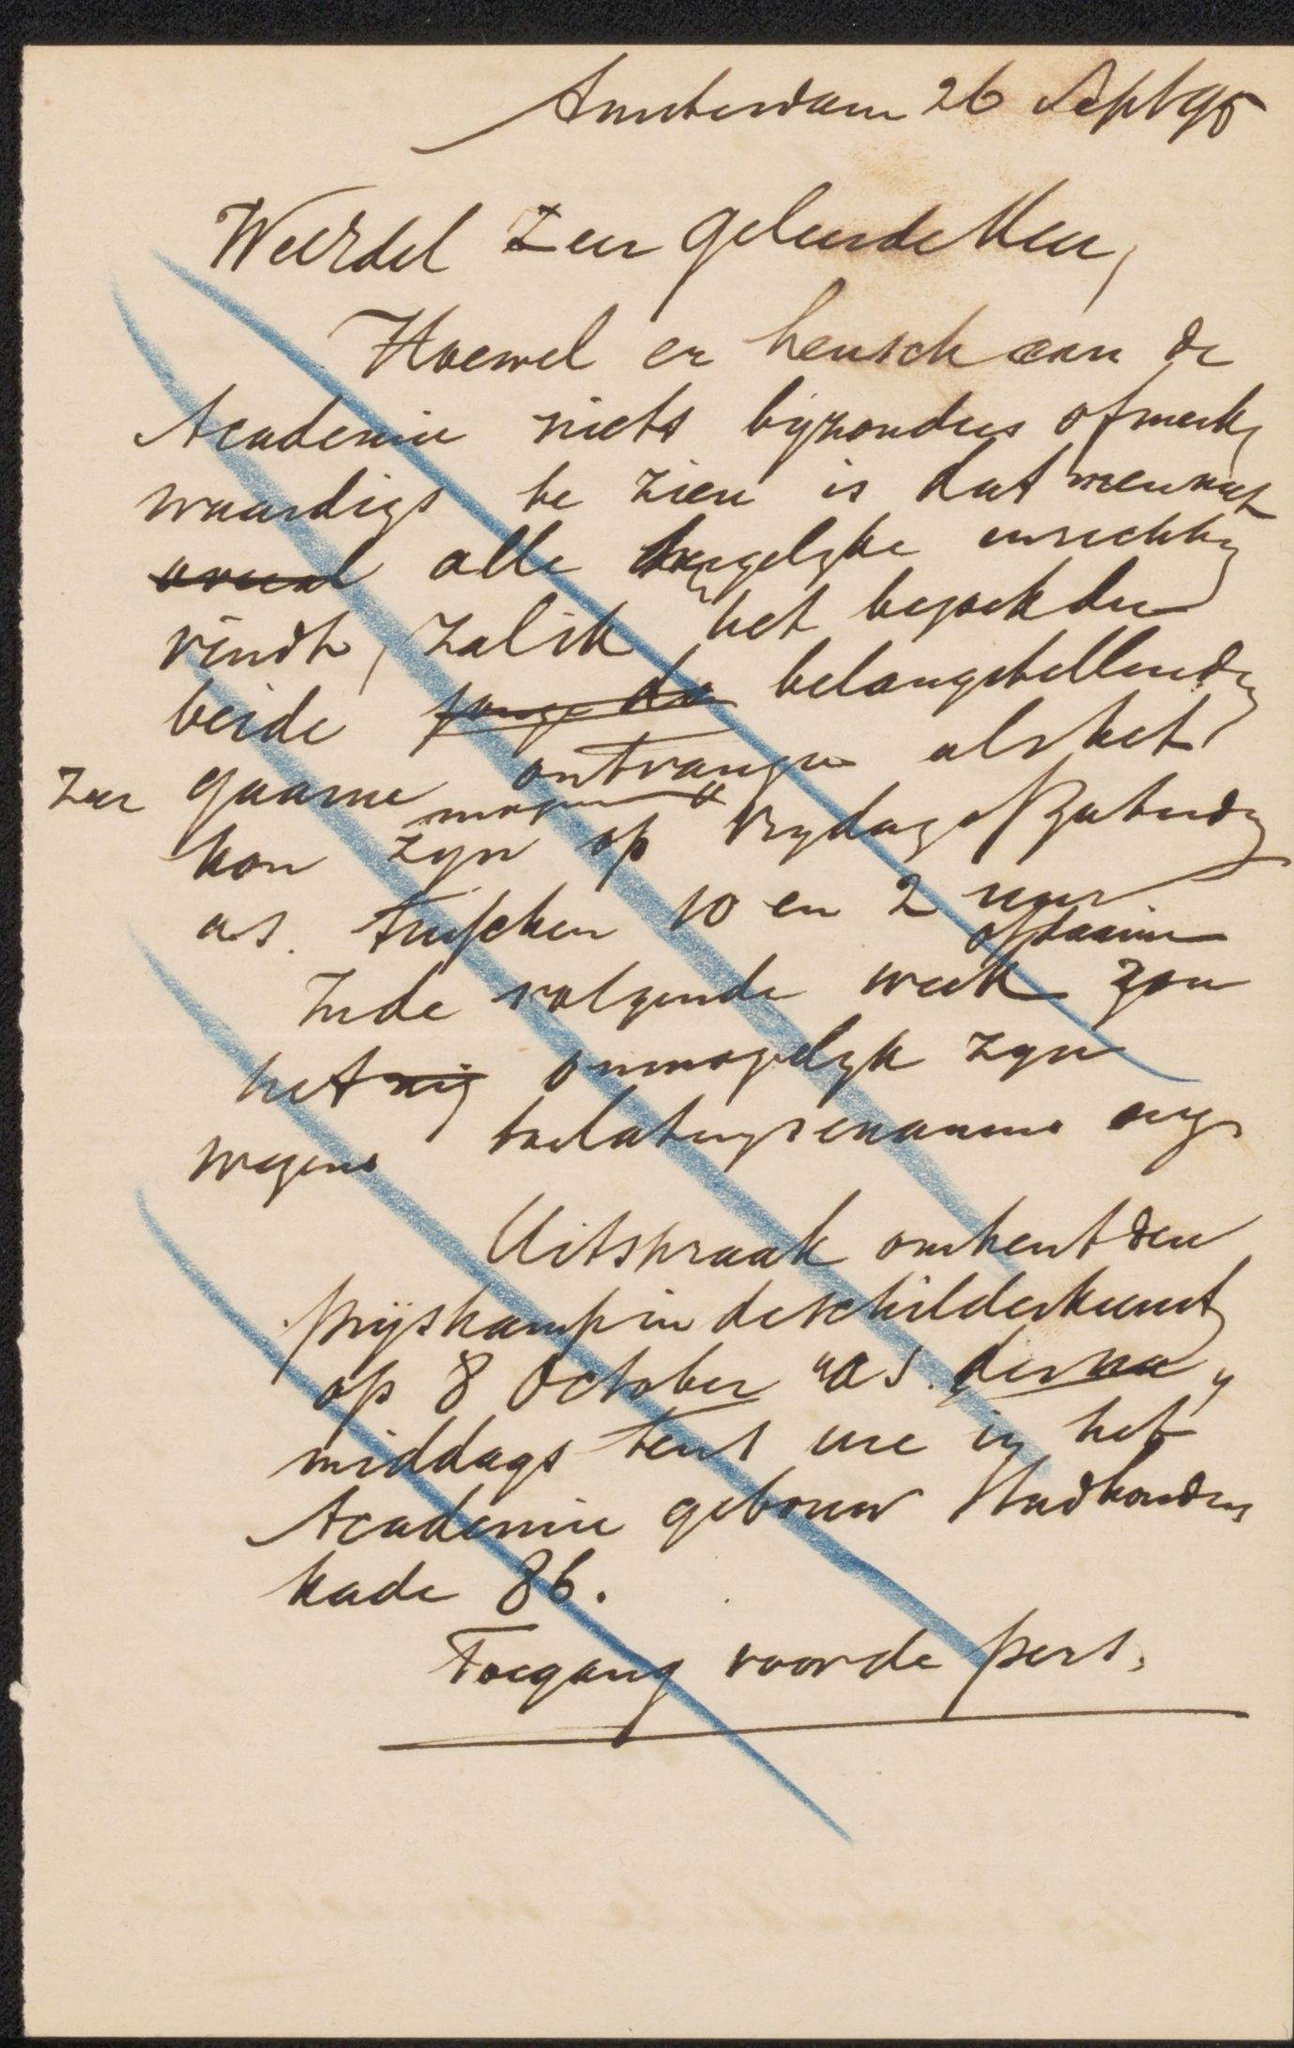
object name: letter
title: Conceptbrieven aan anoniem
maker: august allebé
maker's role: draughtsman, print maker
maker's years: 1838-1927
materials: ink, paper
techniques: pen, writing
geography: amsterdam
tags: print maker, johannes hendricus jurres, distribution of awards ~ art contest, education, tuition of the artist (in general), painting (including book-illumination, miniature-painting), money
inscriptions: watermark